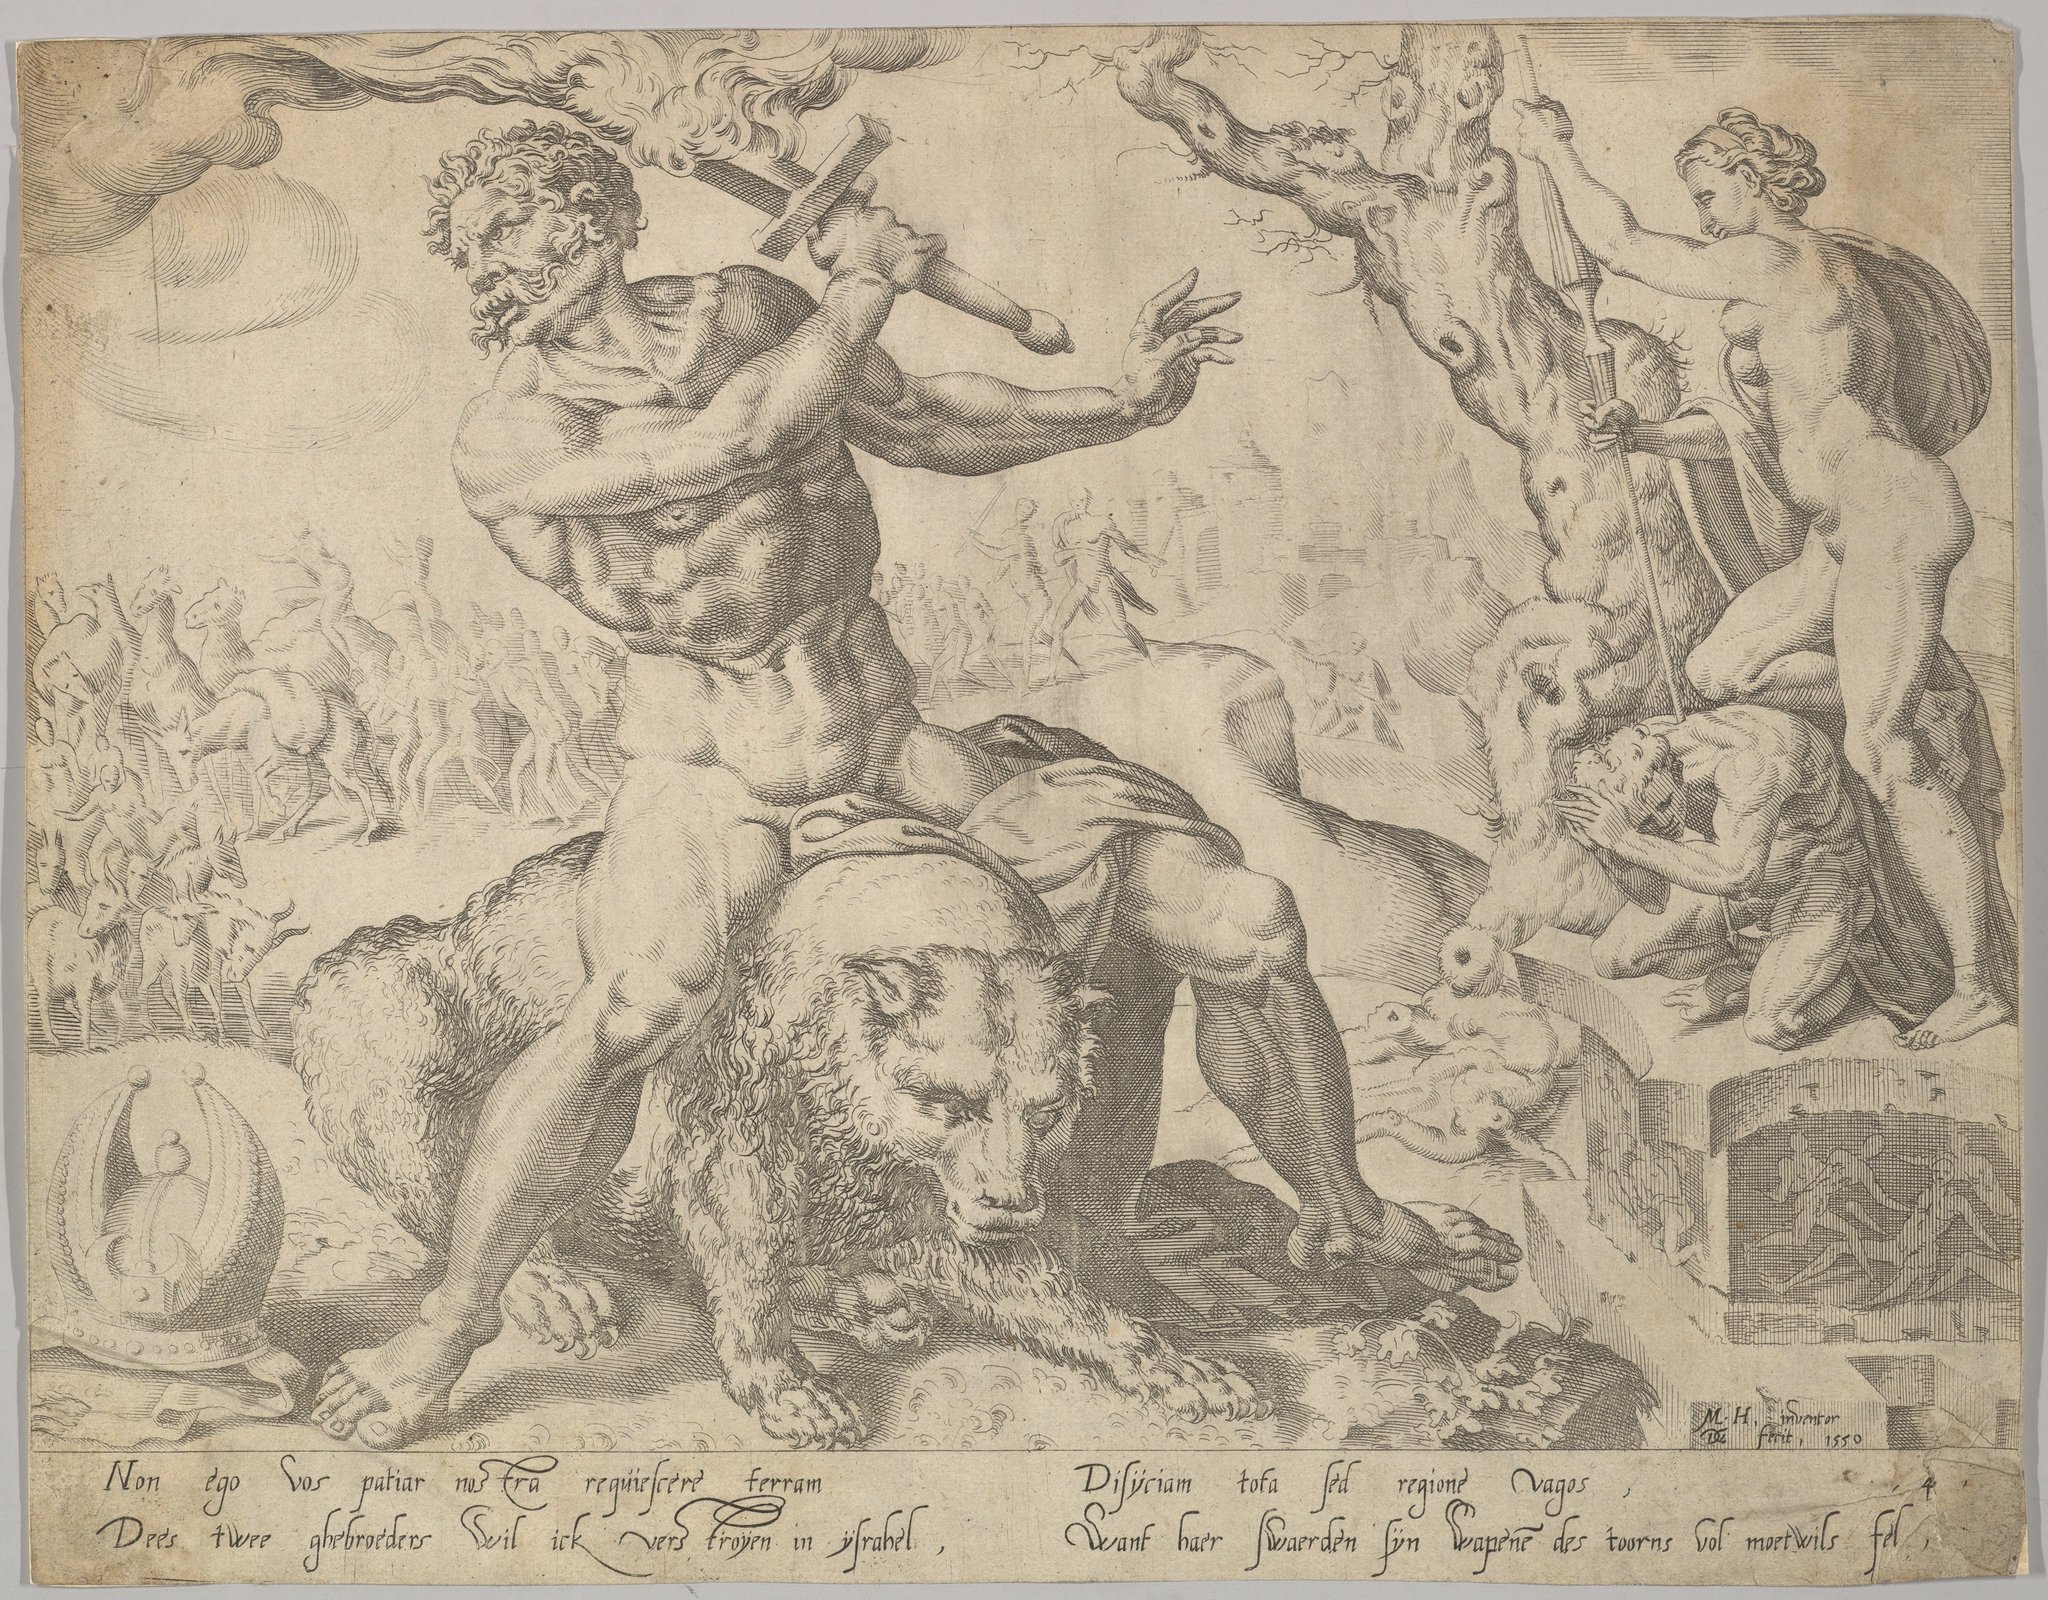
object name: print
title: Levi, from the series The Twelve Patriarchs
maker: maarten van heemskerck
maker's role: artist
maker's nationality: netherlandish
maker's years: 1498-1574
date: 1550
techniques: etching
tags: animals,swords,male nudes,female nudes